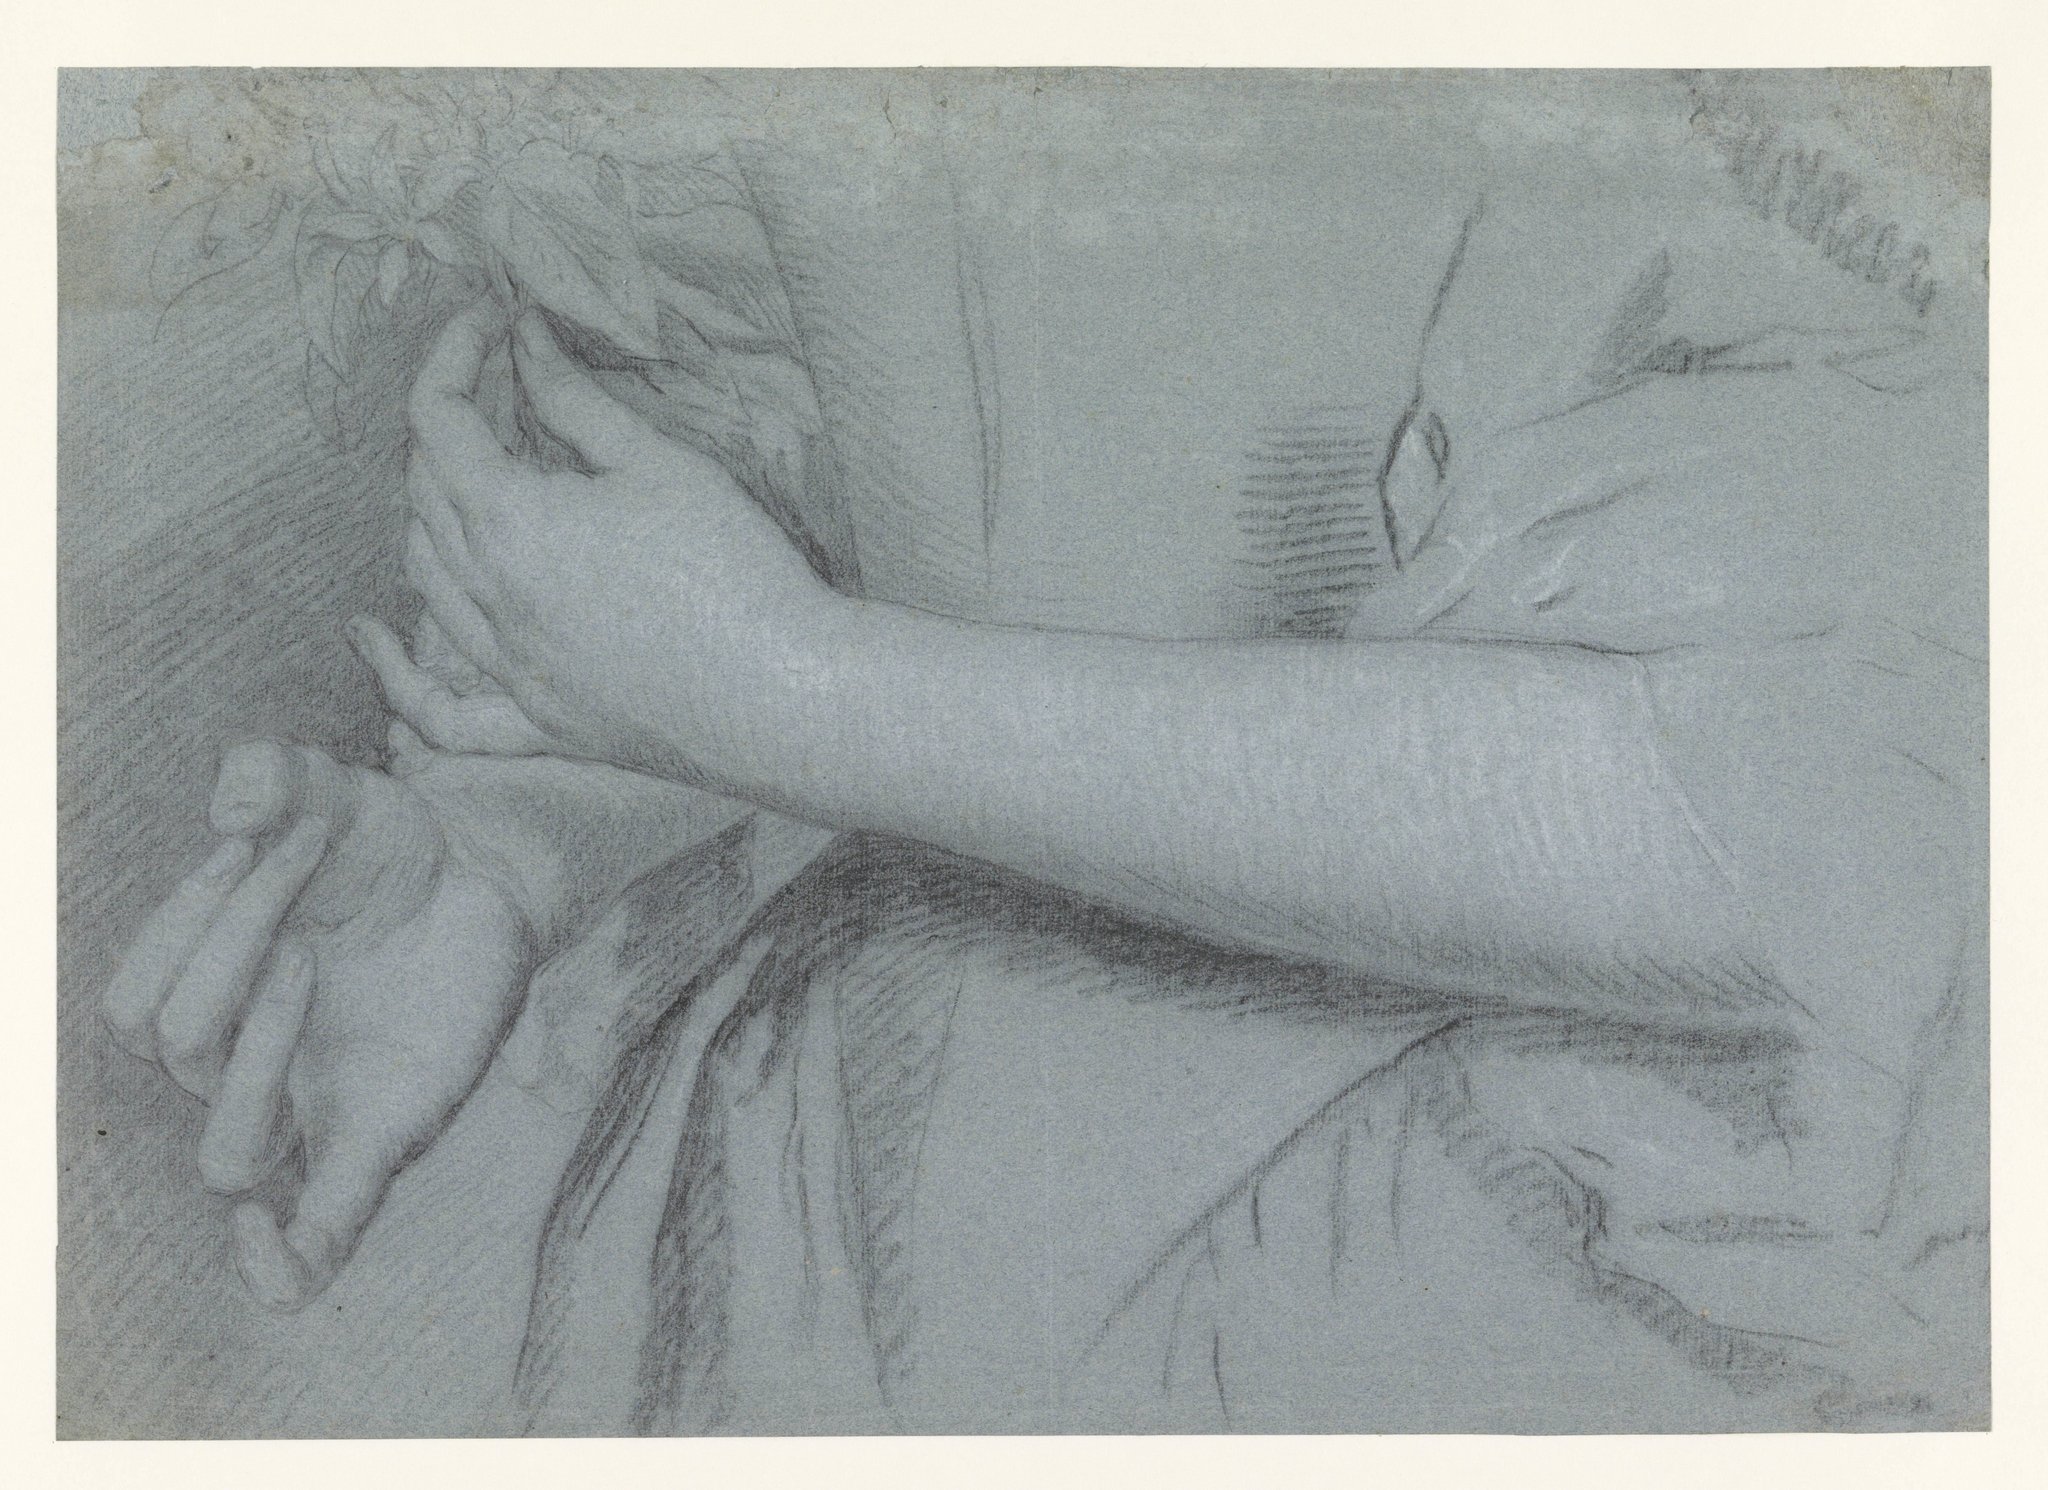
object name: drawing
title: Taille van een vrouw, arm en handen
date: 1603-1662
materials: chalk, paper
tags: hand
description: Afkomstig uit een tekeningenalbum met onder andere figuur- en handstudies van of naar Caspar en Constantijn Netscher (BI-1894-3720). Tekening bevond zich oorspronkelijk op f. 27.